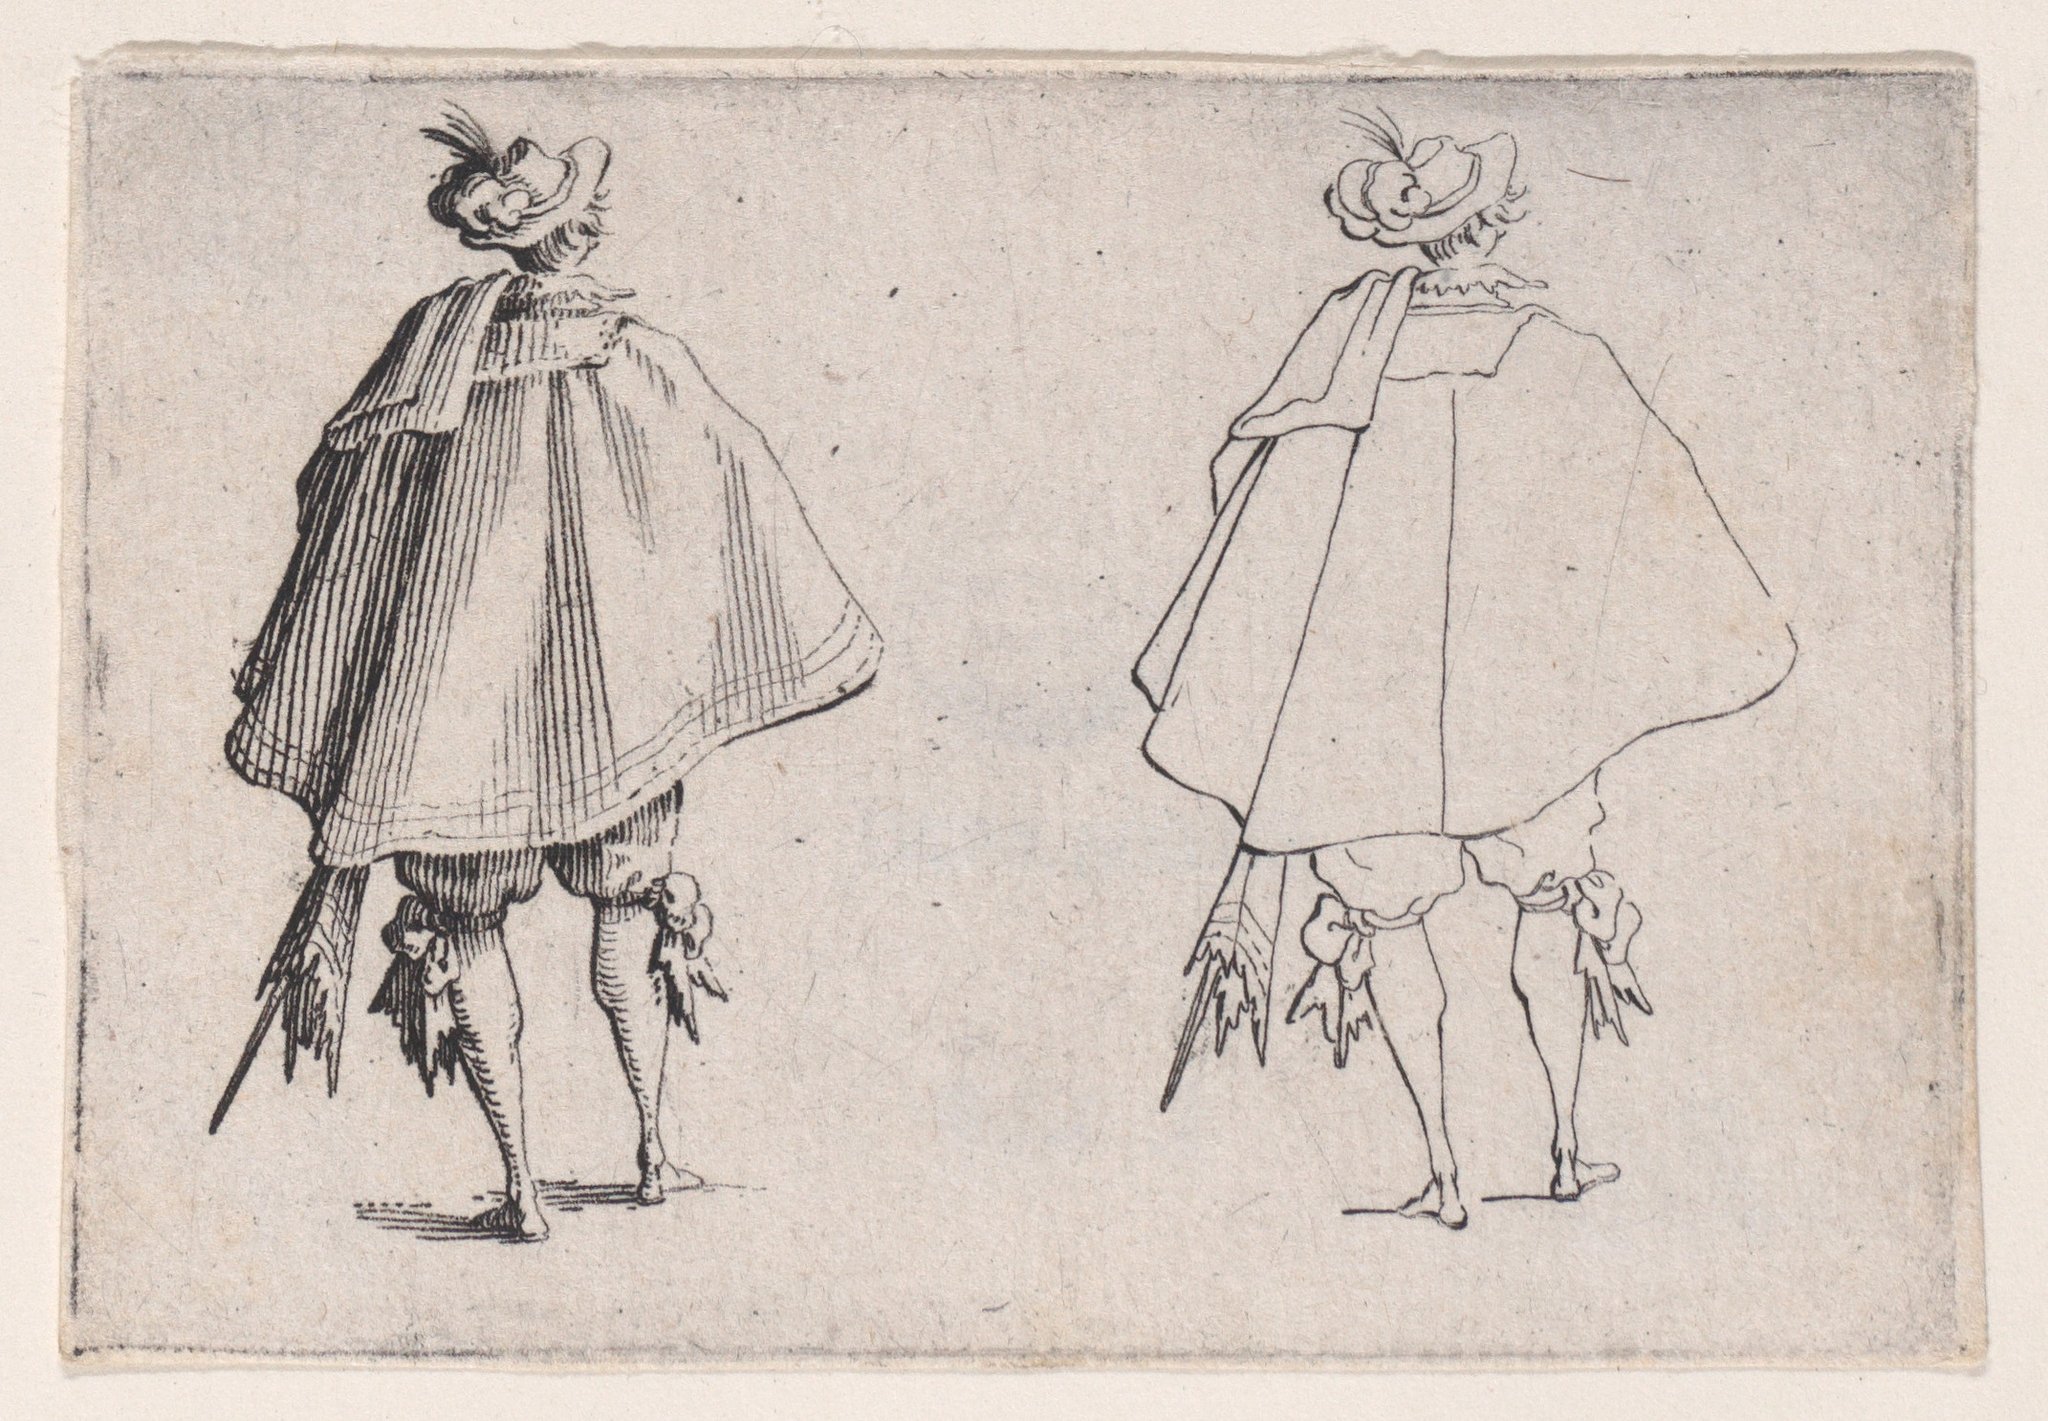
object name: print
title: Le Gentilhomme au Grand Manteau, Vu de Dos (The Gentleman with the Large Mantle, Seen from Behind), from Les Caprices Series A, The Florence Set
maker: jacques callot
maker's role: artist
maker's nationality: french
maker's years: 1592-1635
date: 1617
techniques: etching